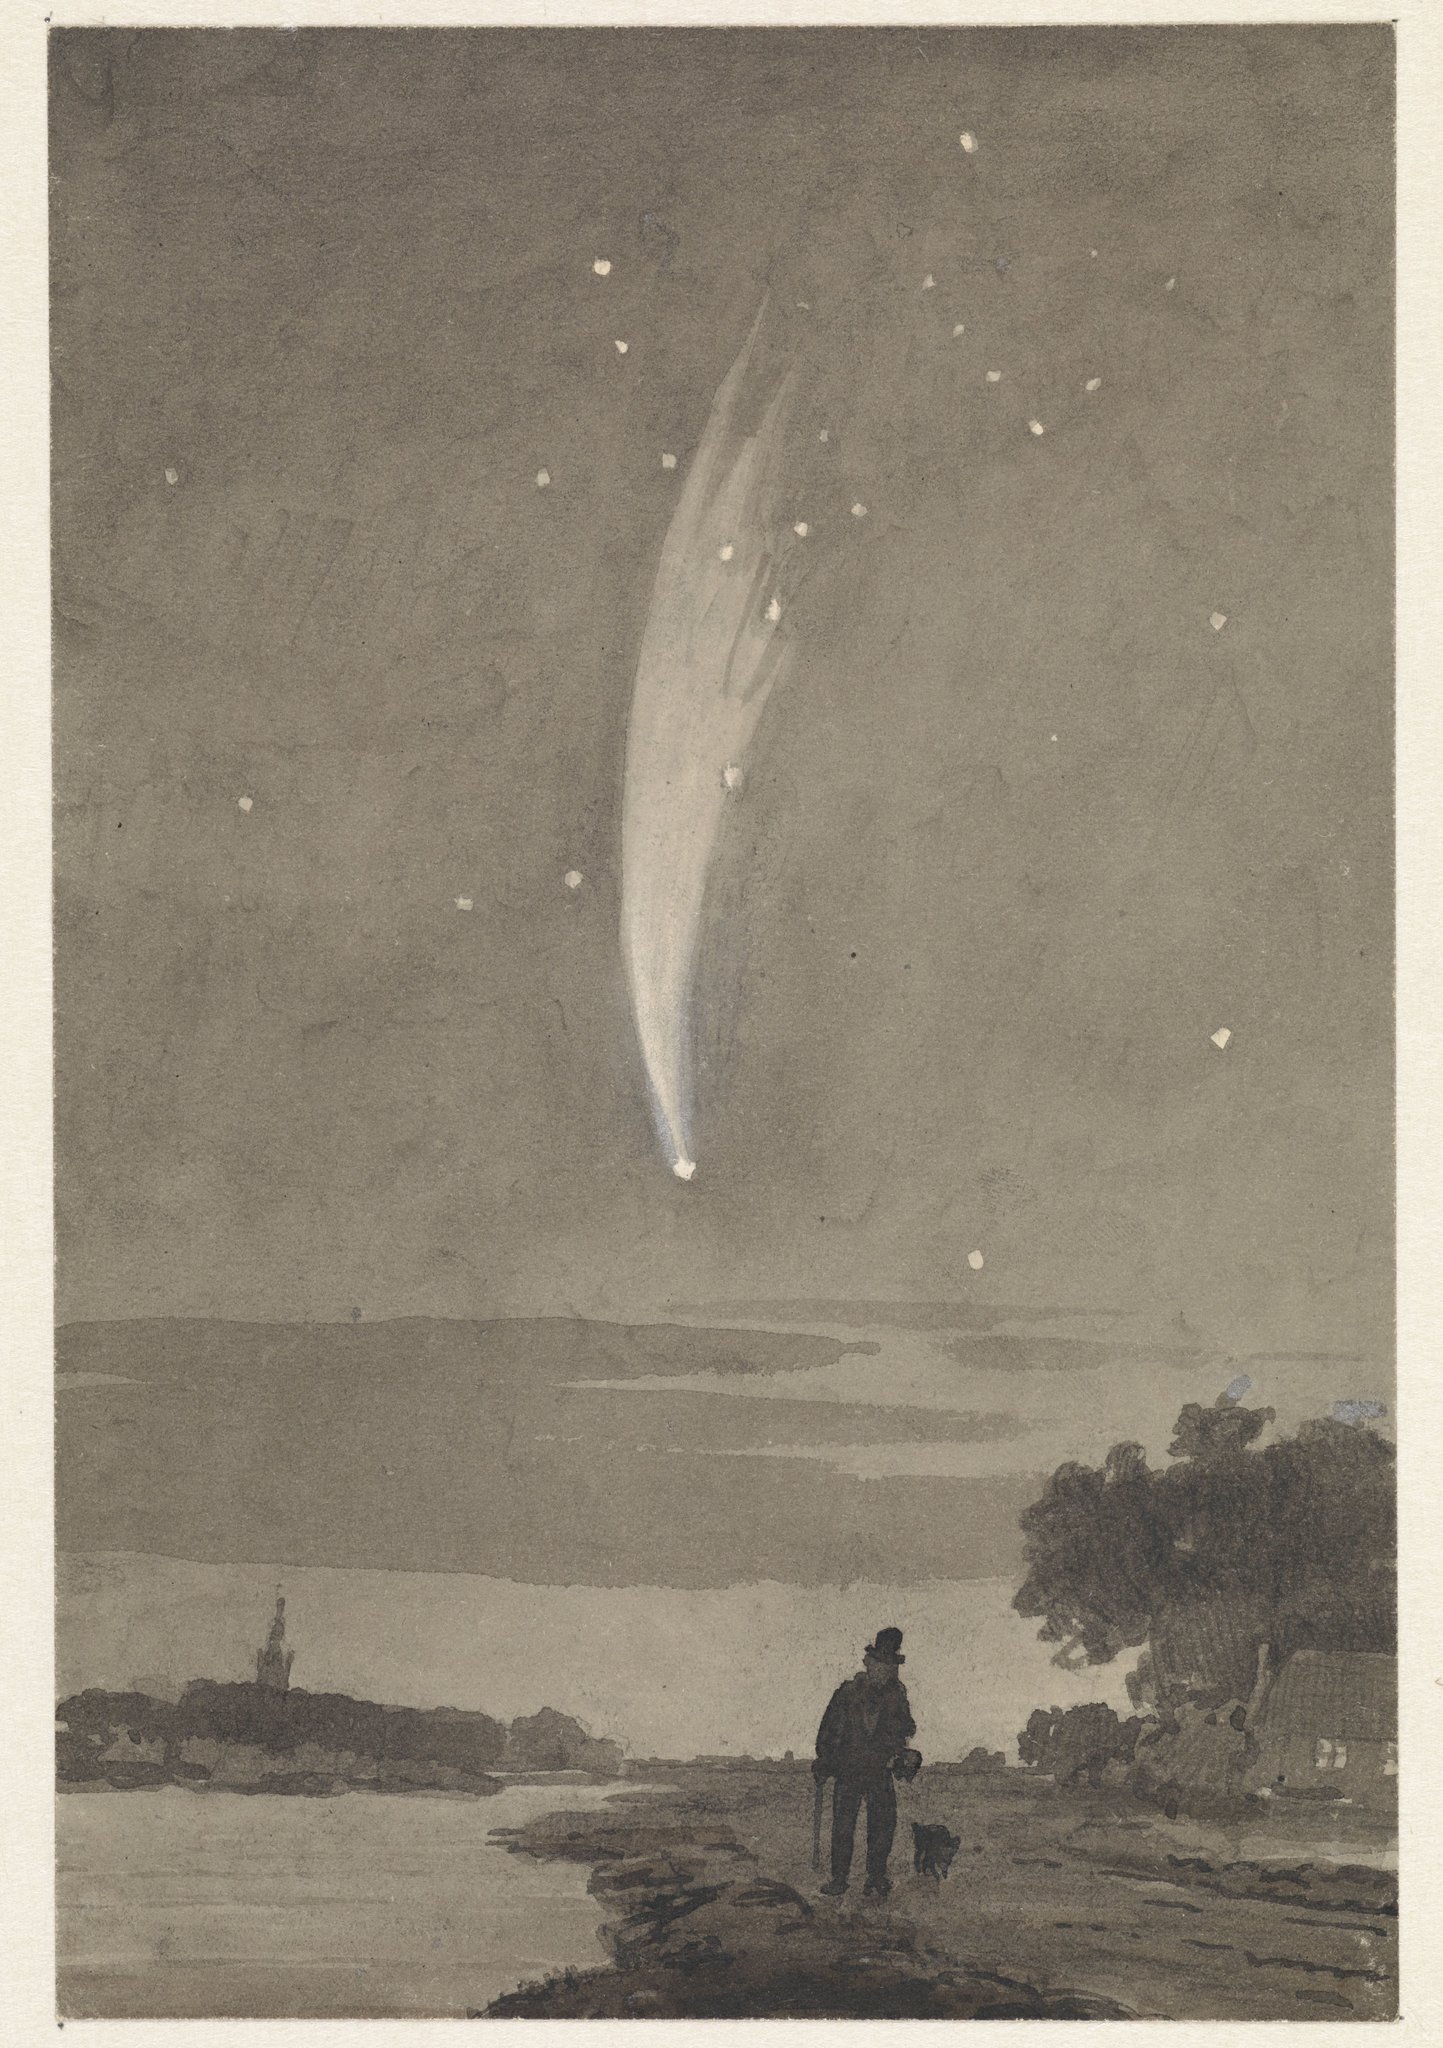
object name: drawing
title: De komeet van Donati, 10 oktober 1858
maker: cornelis van der griendt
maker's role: draughtsman, painter, print maker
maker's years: 1827-1918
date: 1837-1918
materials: paint, paper, pencil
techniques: brush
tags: (other) historical names, comet, historical events and situations